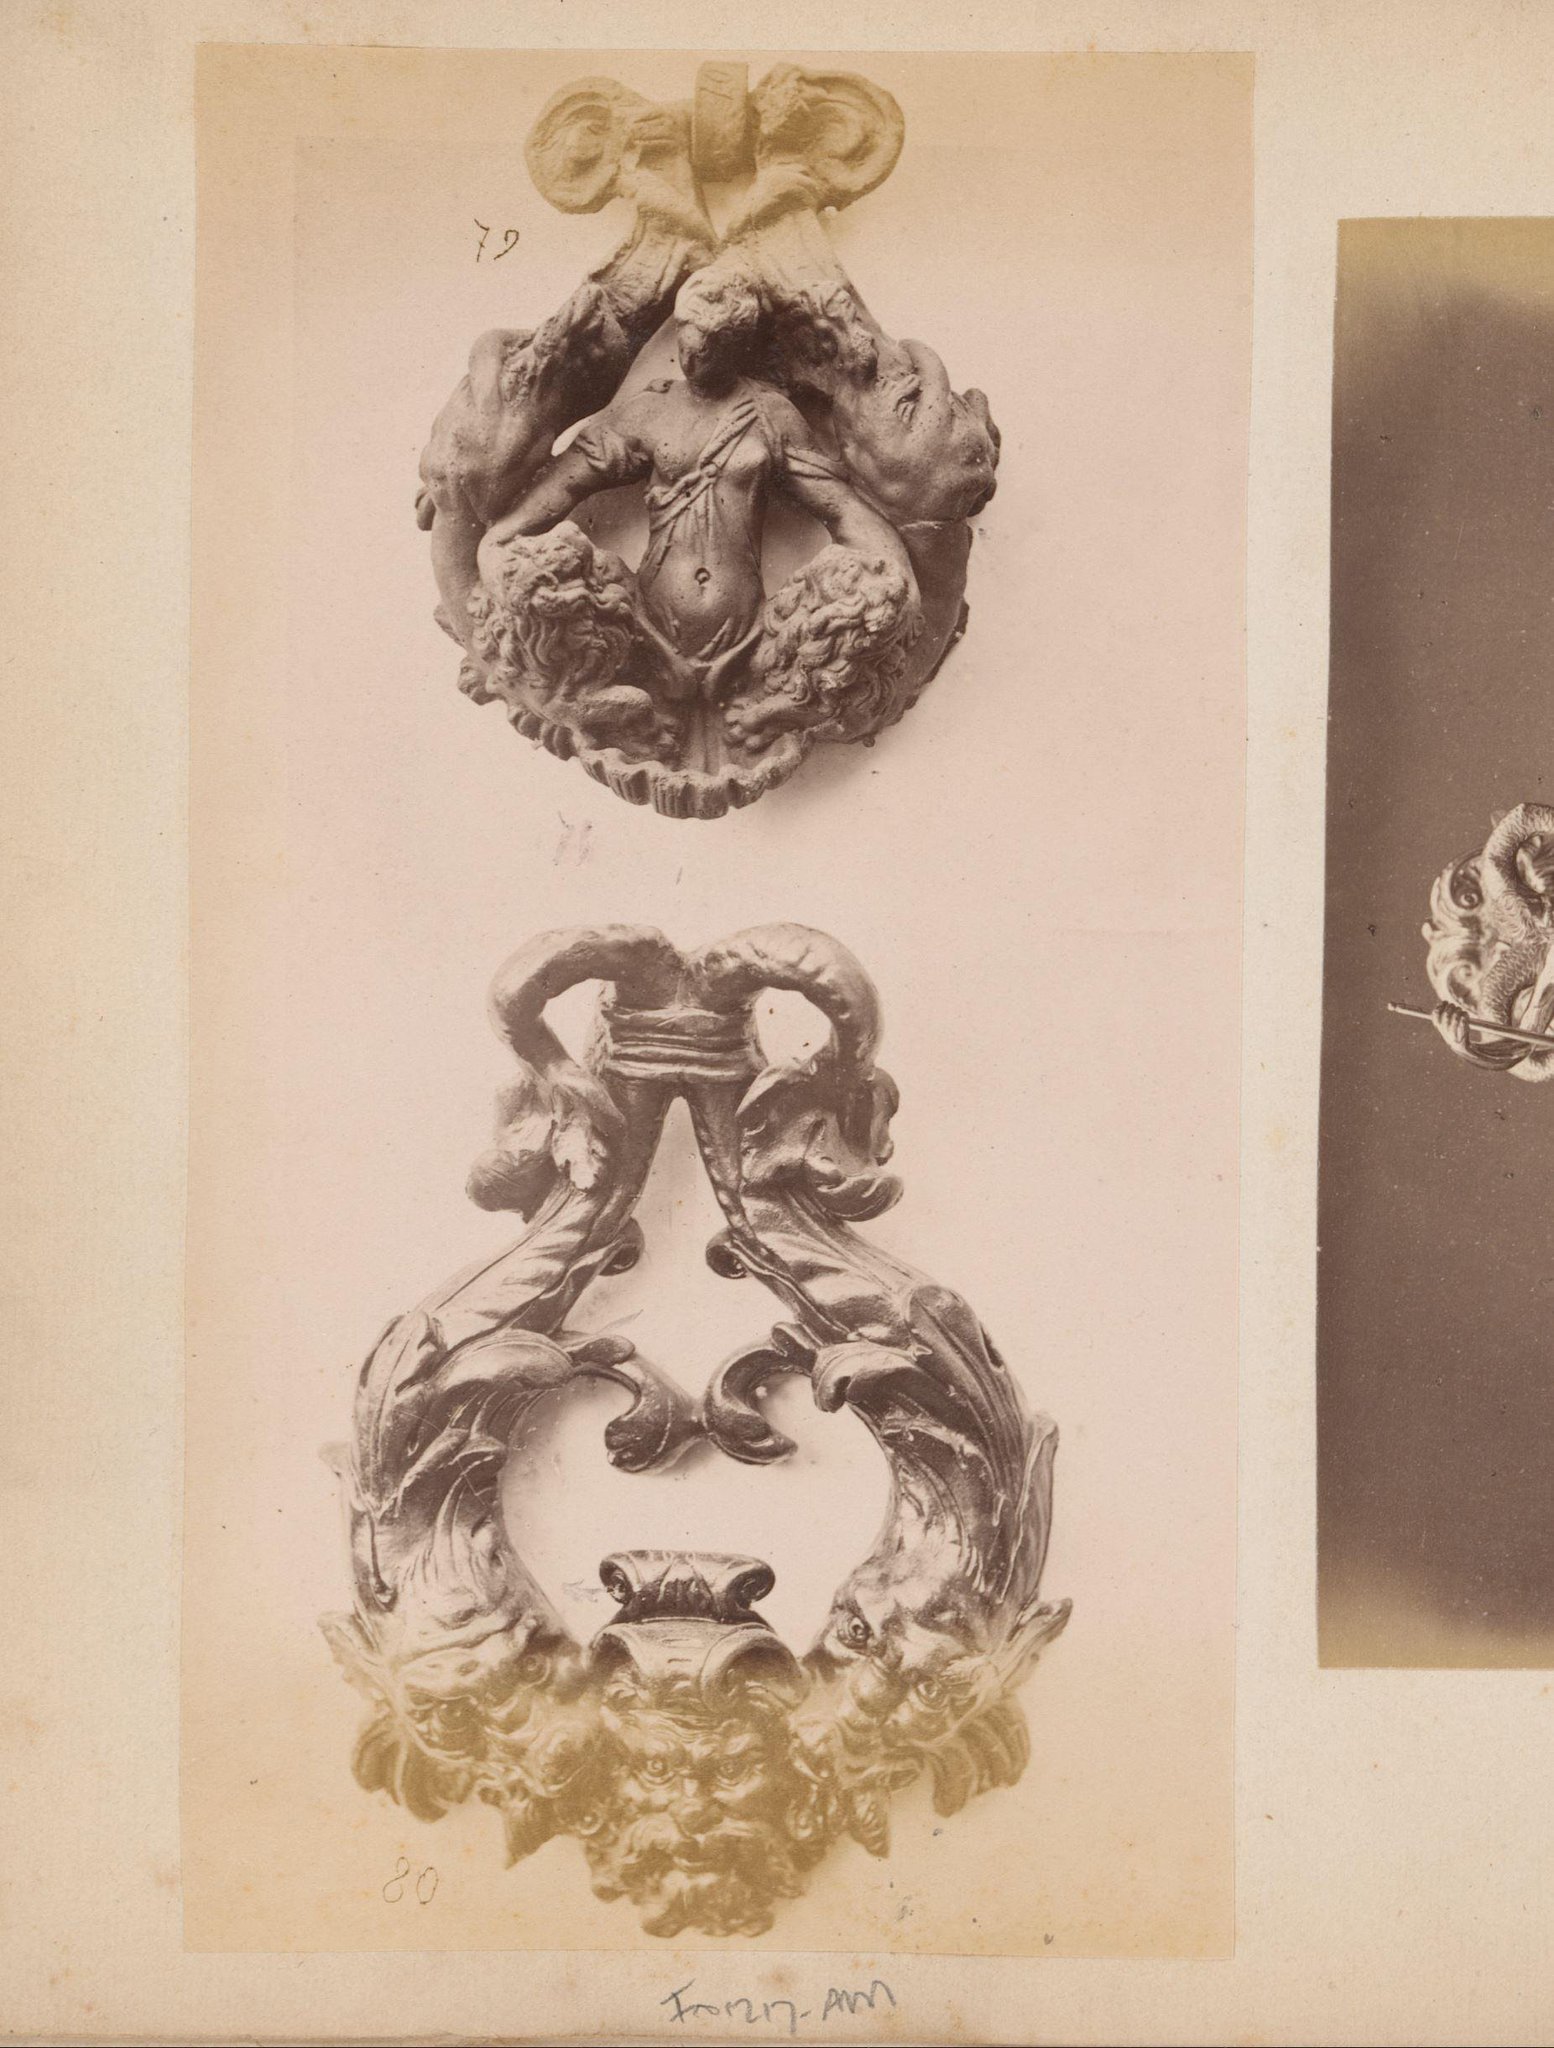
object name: photograph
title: Metalen deurkloppers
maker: Anonymous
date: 1860-1885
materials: photographic support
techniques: albumen print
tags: door-knocker, doorbell